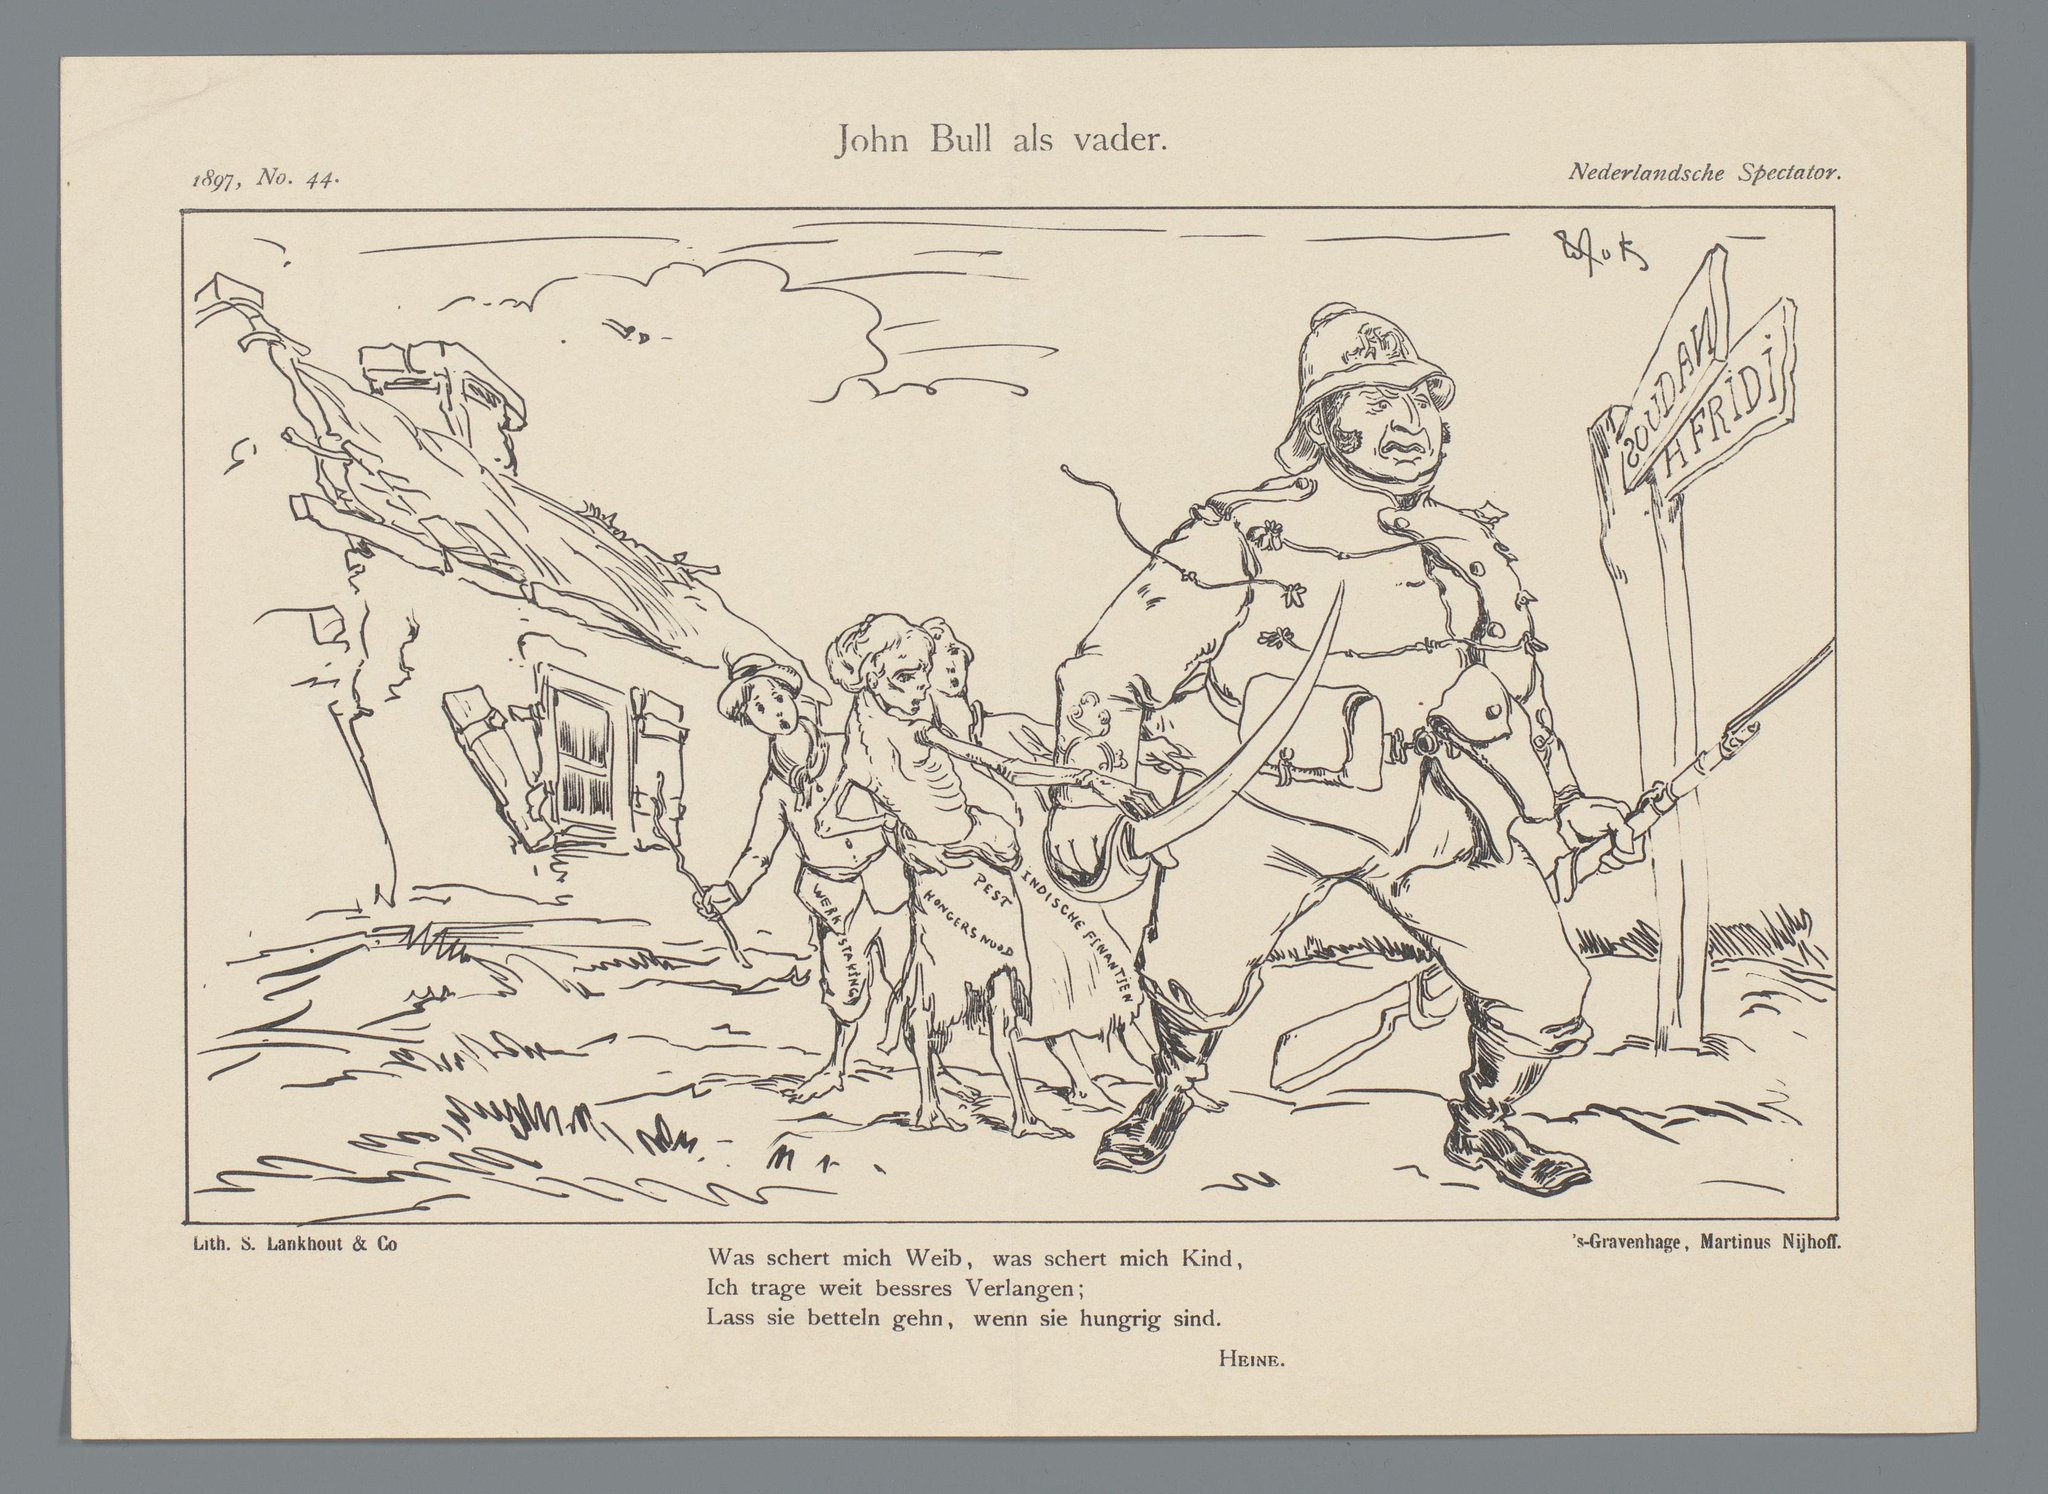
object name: cartoon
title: John Bull als vader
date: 1897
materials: paper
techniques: lithograph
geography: netherlands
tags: personifications of countries, nations, states, districts, etc., political caricatures and satires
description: John Bull (Engeland) trekt erop uit met ontbloot sabel richting Soedan, drie arme kinderen proberen hem thuis te houden. Onderaan een drieregelig vers van Heine. Verschenen als bijlage bij De Nederlandsche Spectator, 1897, nr. 44.